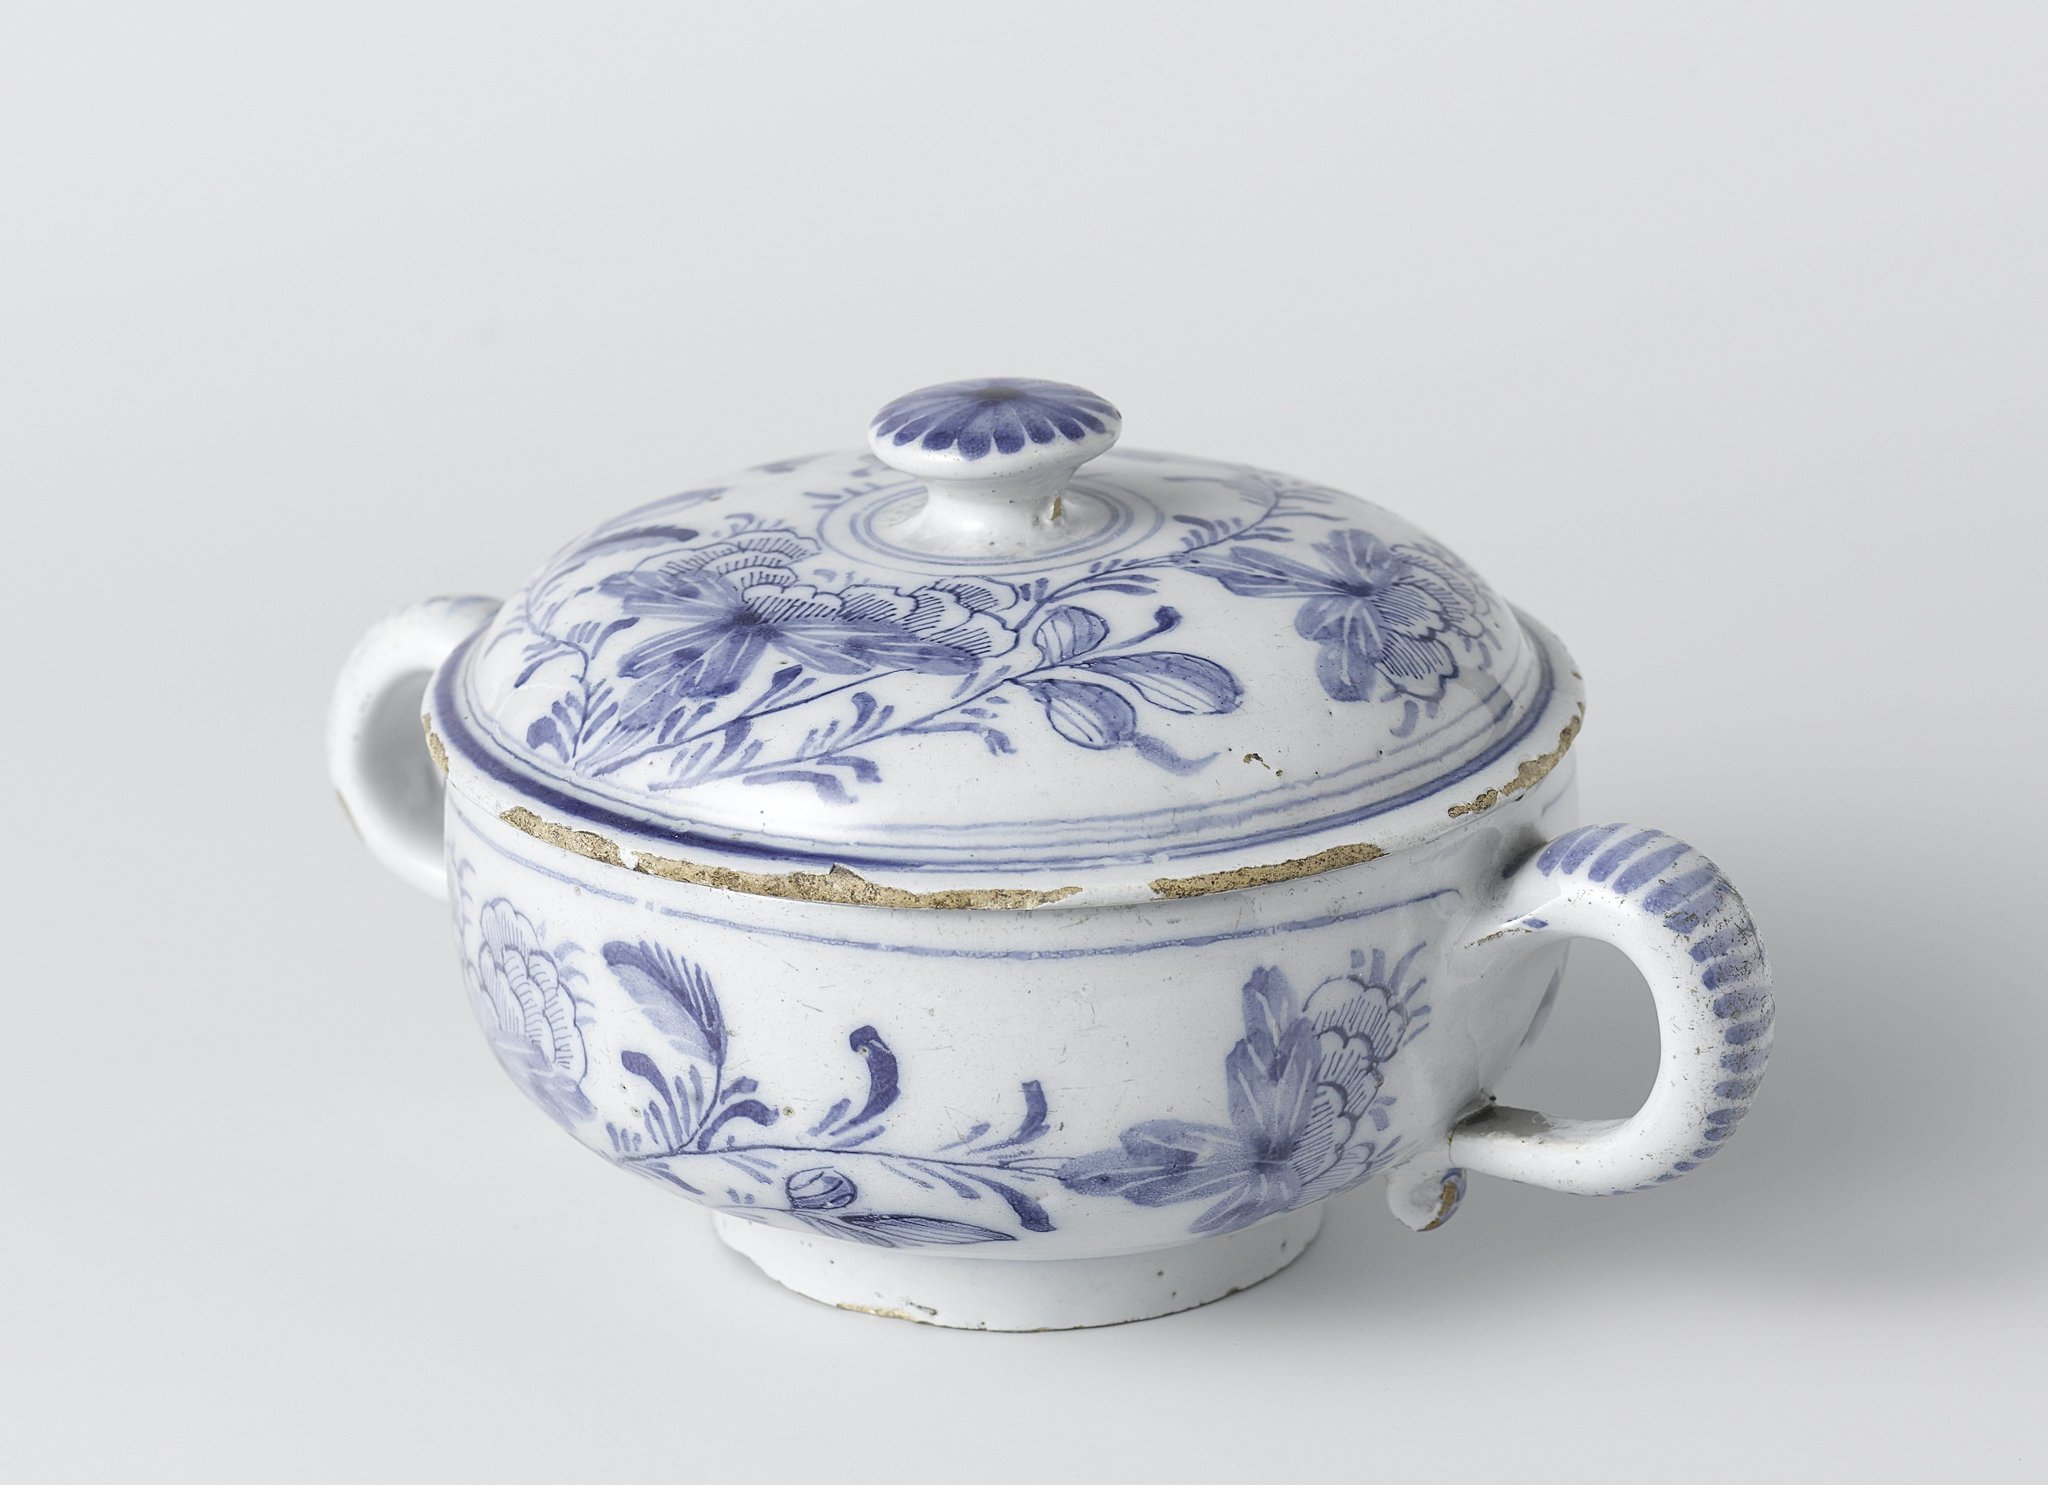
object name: lid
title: Boterpot met deksel van faience met blauwe bloemen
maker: Anonymous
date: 1750-1780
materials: faience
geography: delft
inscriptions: inscription: ‘F[..]/ 18 Dec 80/ f 1,50’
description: Boterpot met deksel van faience. Blauw beschilderd met bloemen.